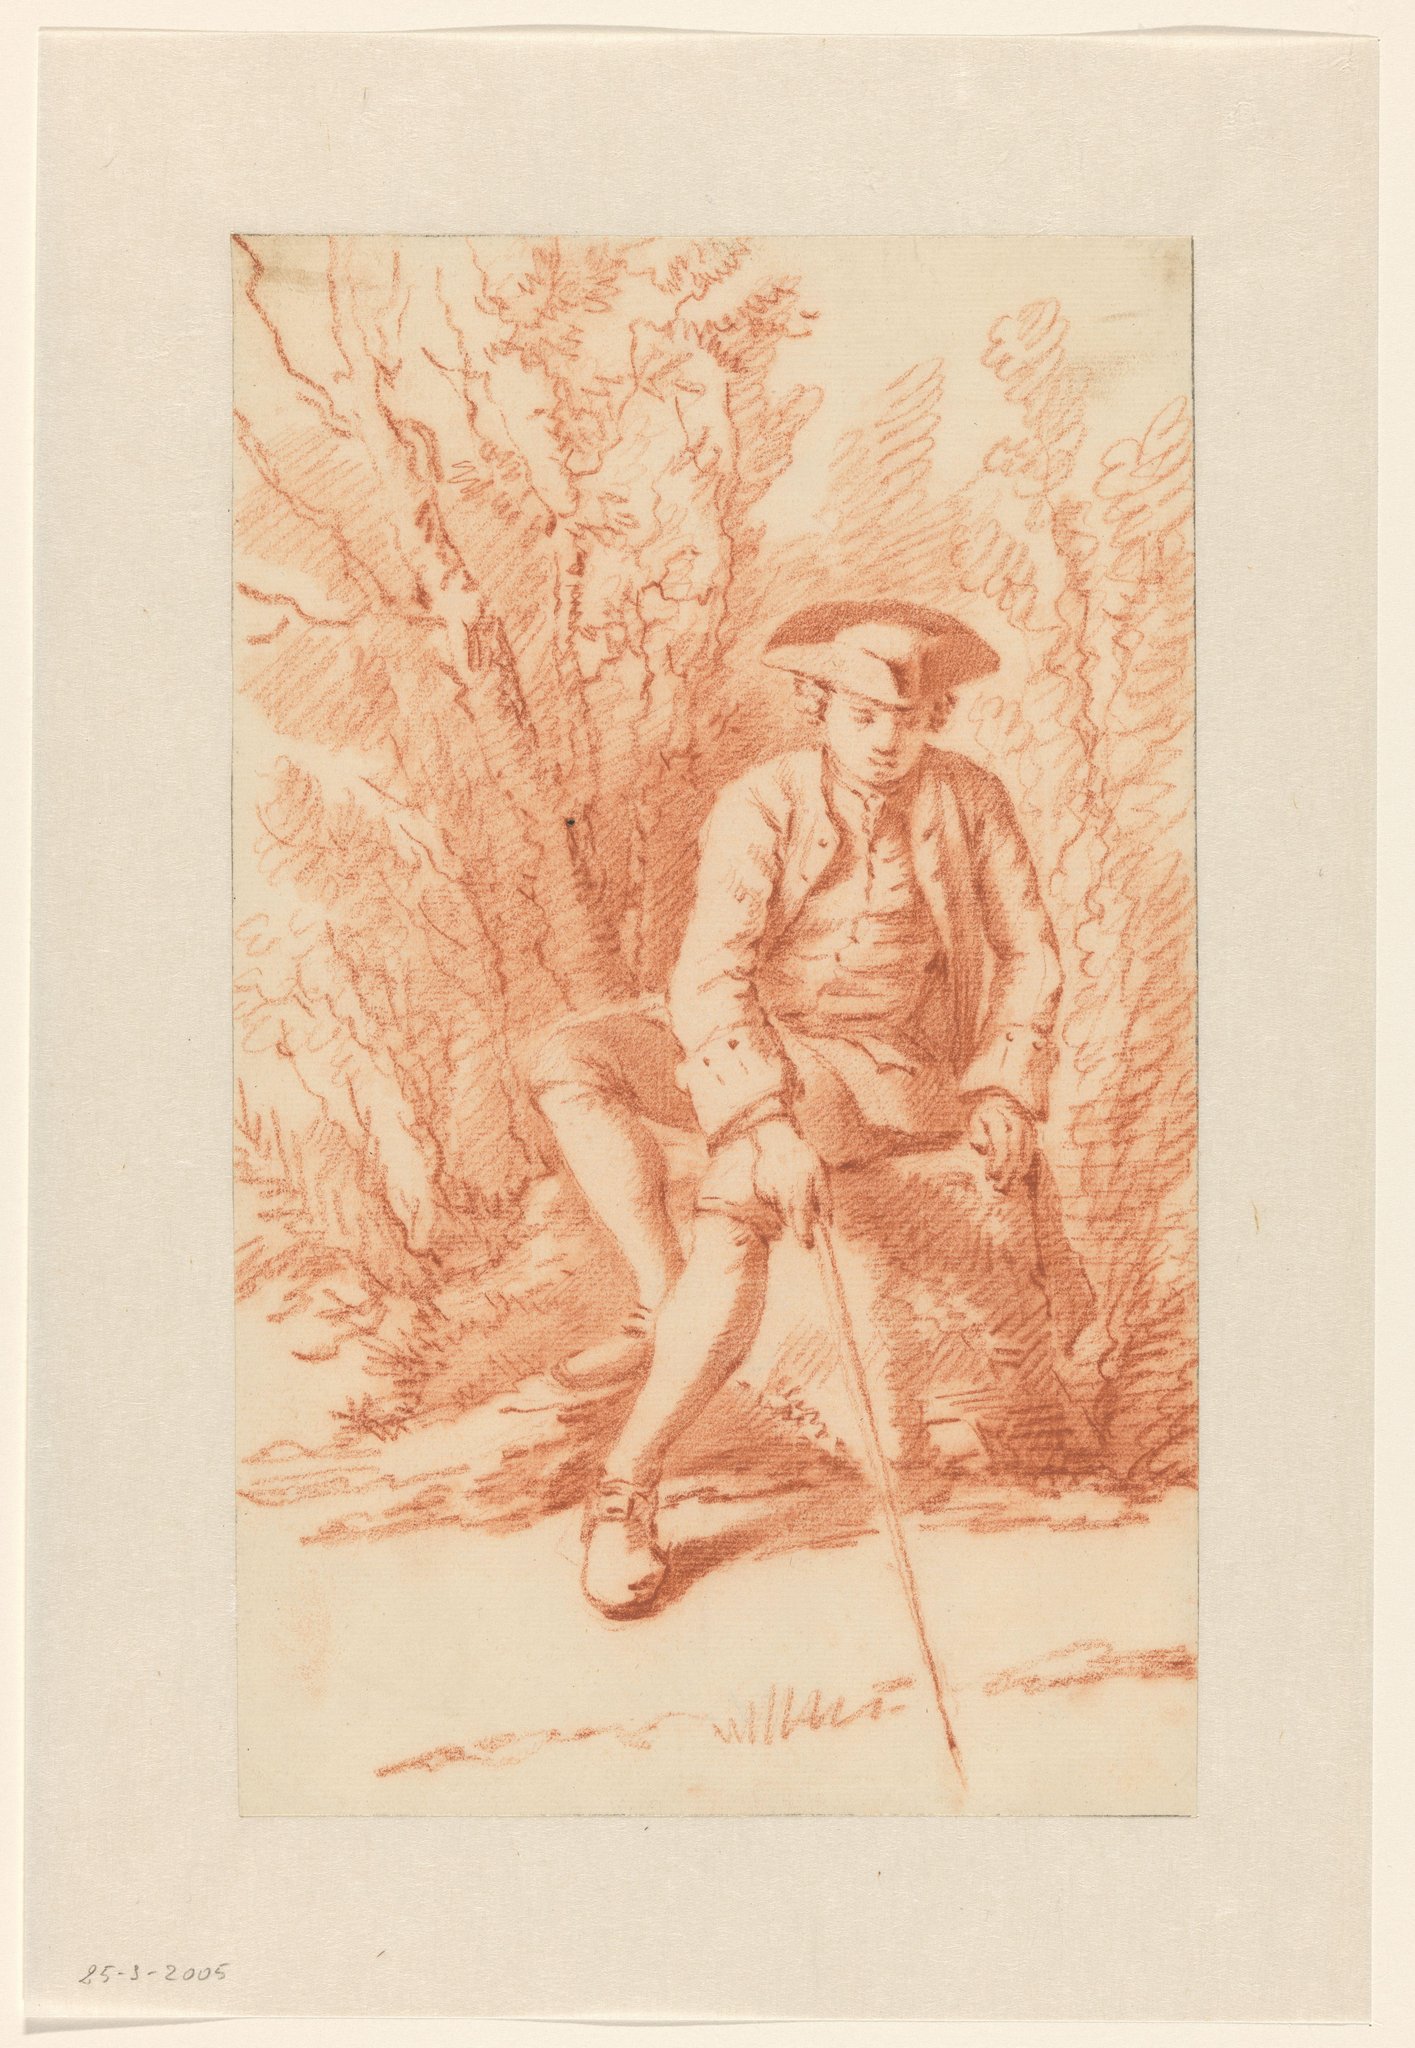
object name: drawing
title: Zittende hengelaar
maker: Anonymous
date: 1700-1800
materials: chalk, paper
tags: angling